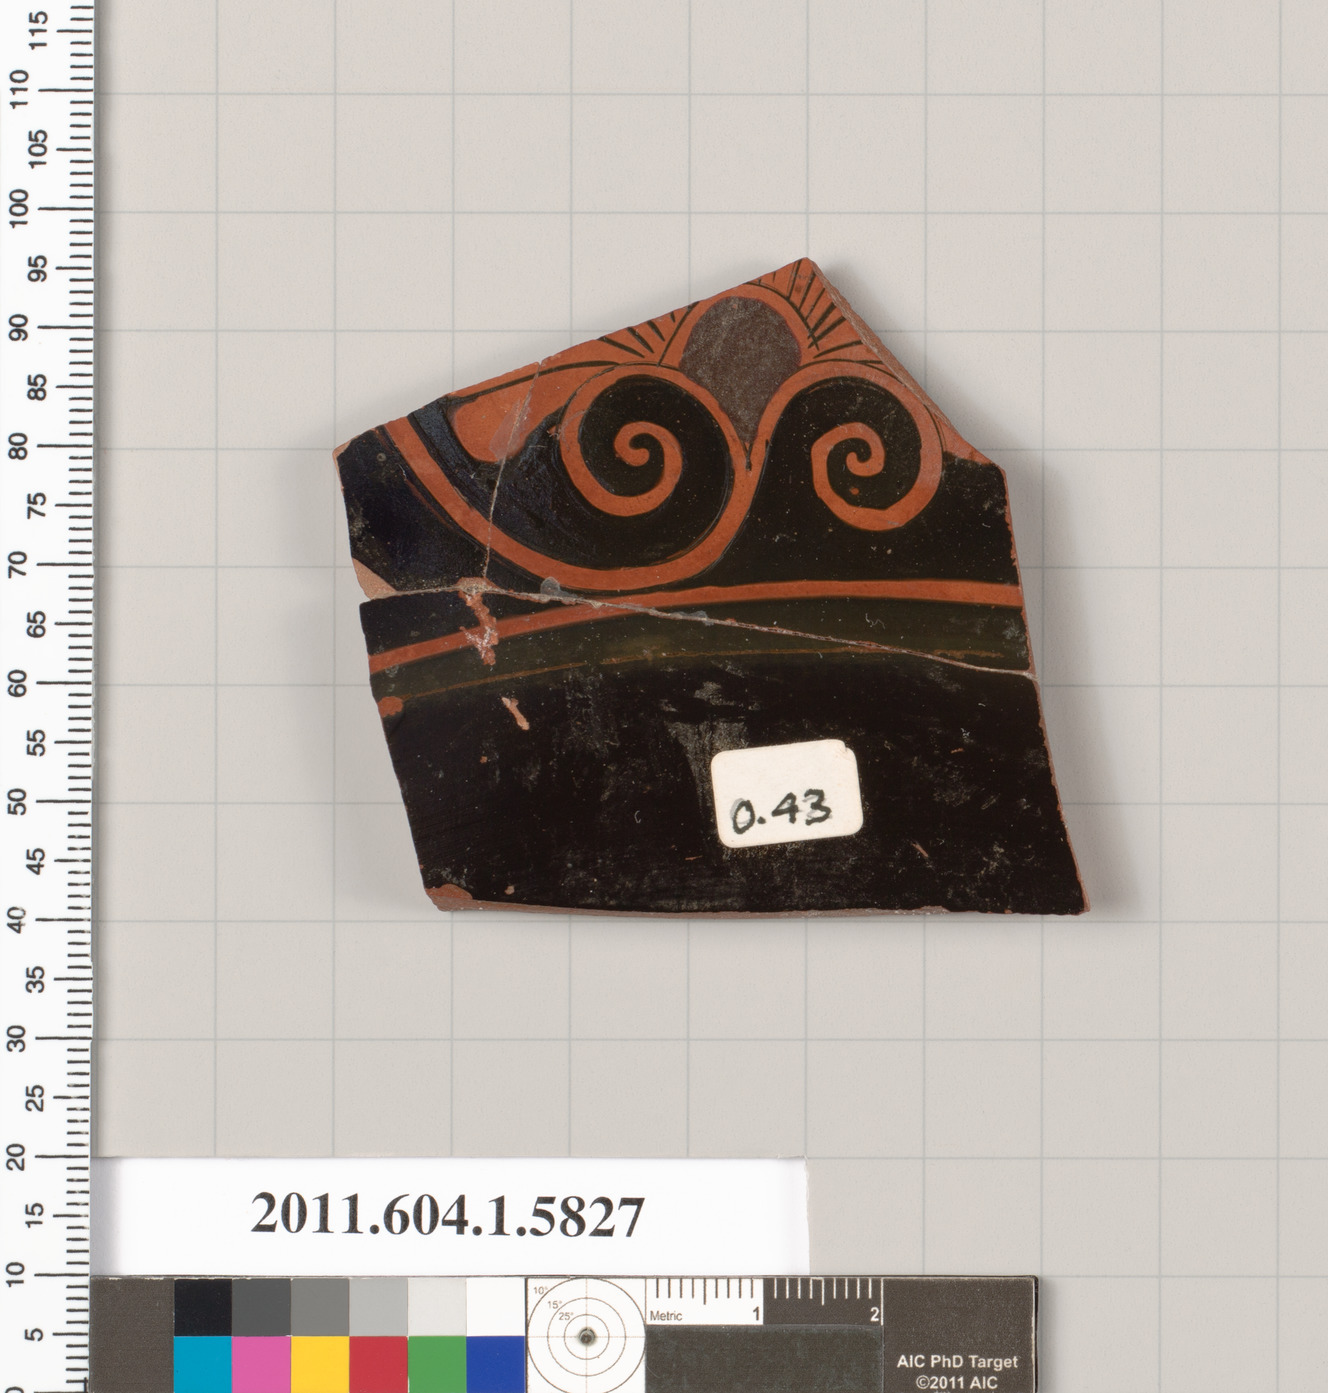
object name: kylix fragment, eye cup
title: Terracotta fragment of a kylix: eye-cup (drinking cup)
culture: greek, attic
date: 520-510 BCE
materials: terracotta